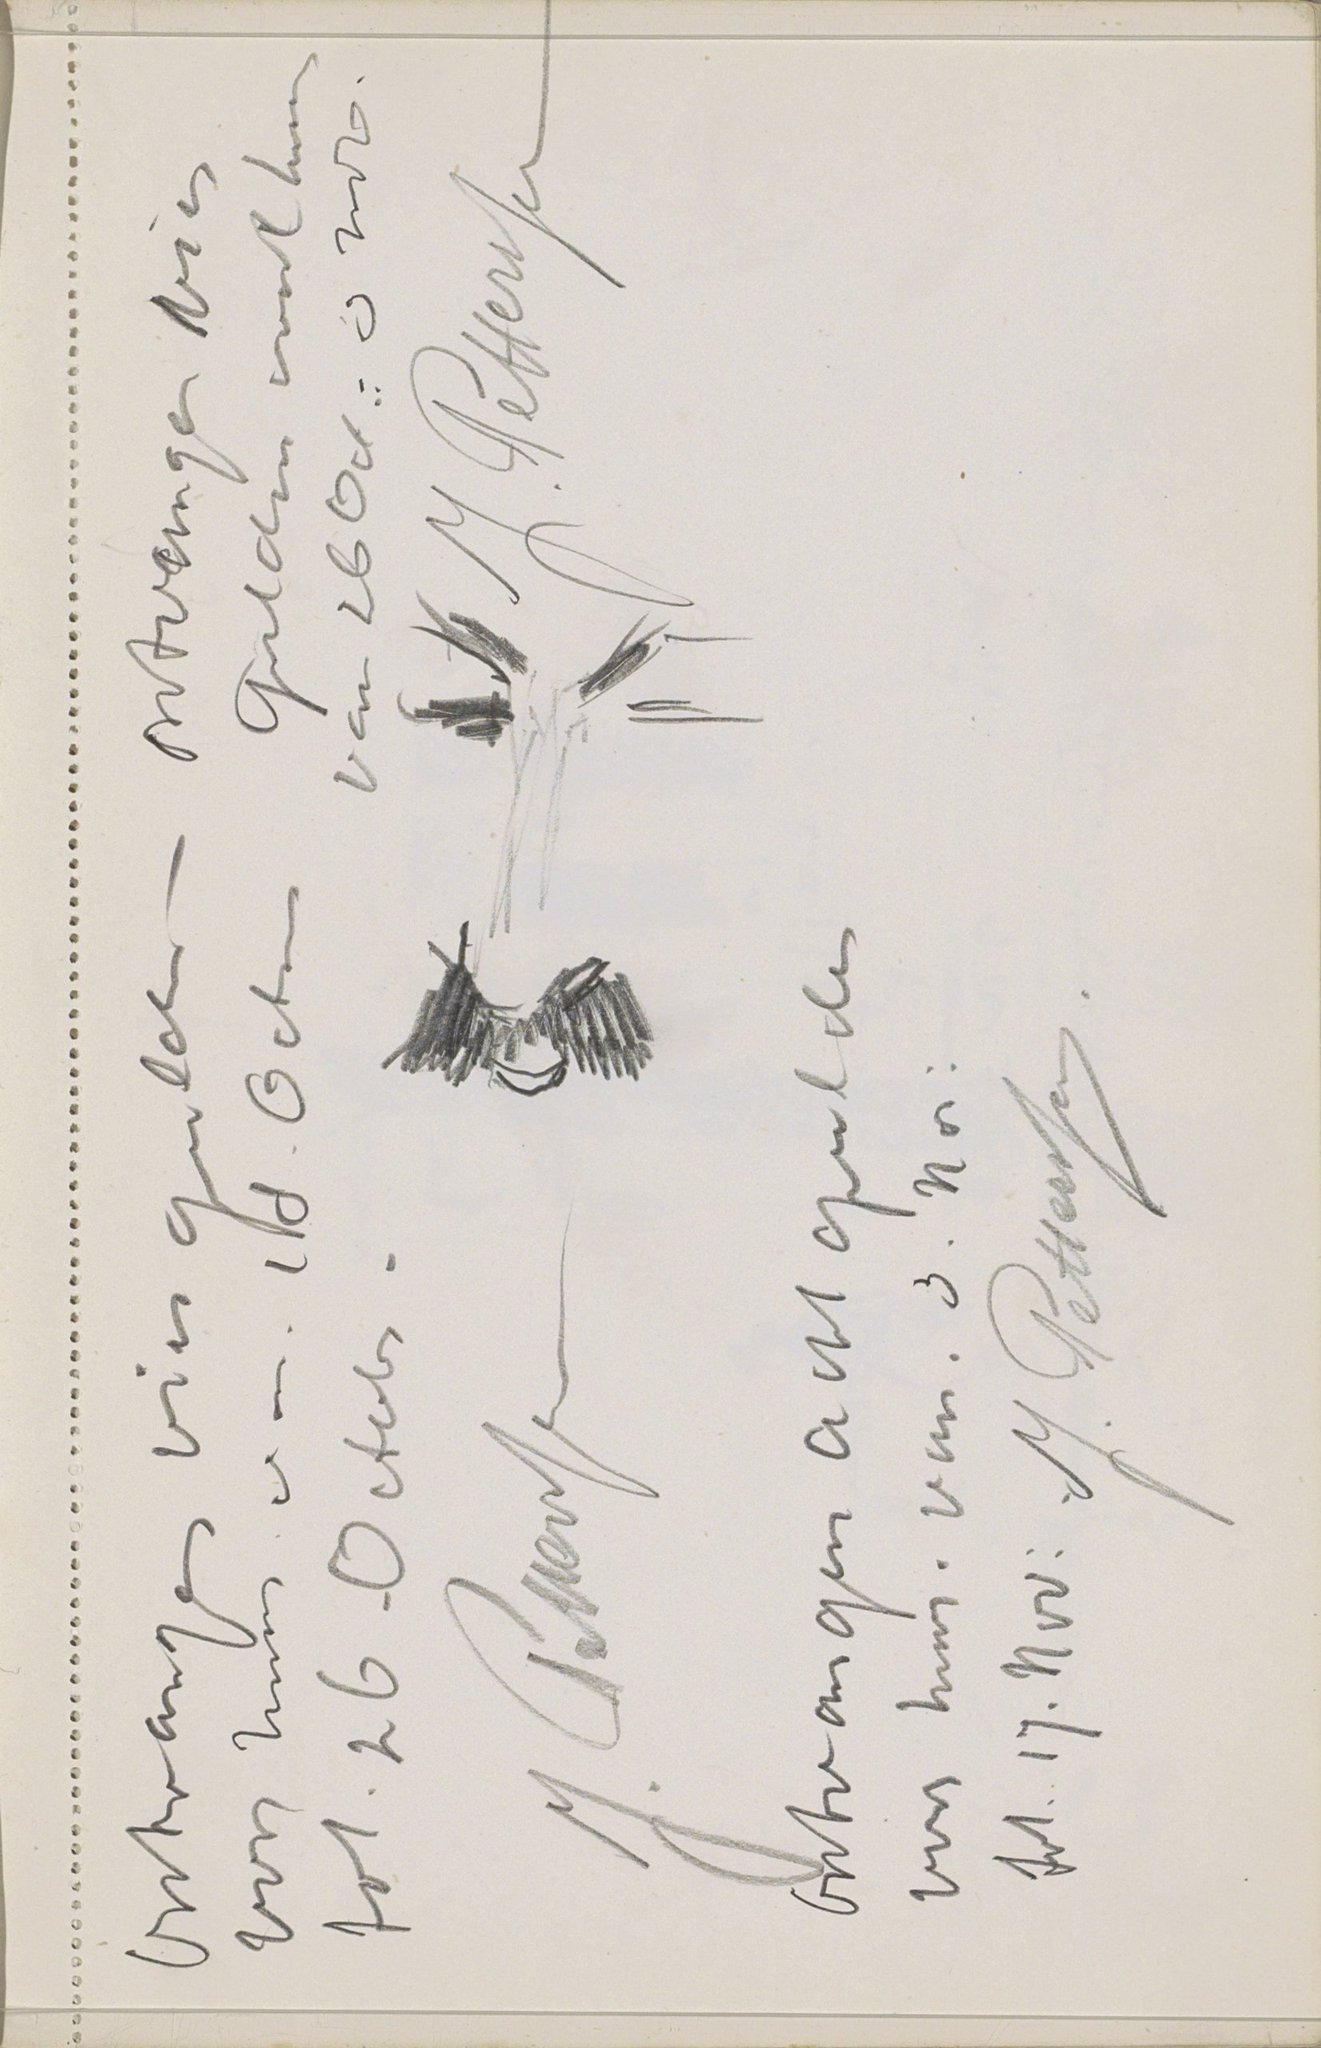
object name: sketchbook leaf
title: Gezicht van een man met een snor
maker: cornelis vreedenburgh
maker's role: draughtsman, print maker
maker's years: 1880-1946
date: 1890-1946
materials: paper, pencil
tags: face, moustache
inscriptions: annotation: ‘ontvangen vier gulden/ voor [...] van 18 Oct/ tot 26 October/ J. Pettersen/ [...]’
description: Blad 19 recto uit een schetsboek met 53 bladen.